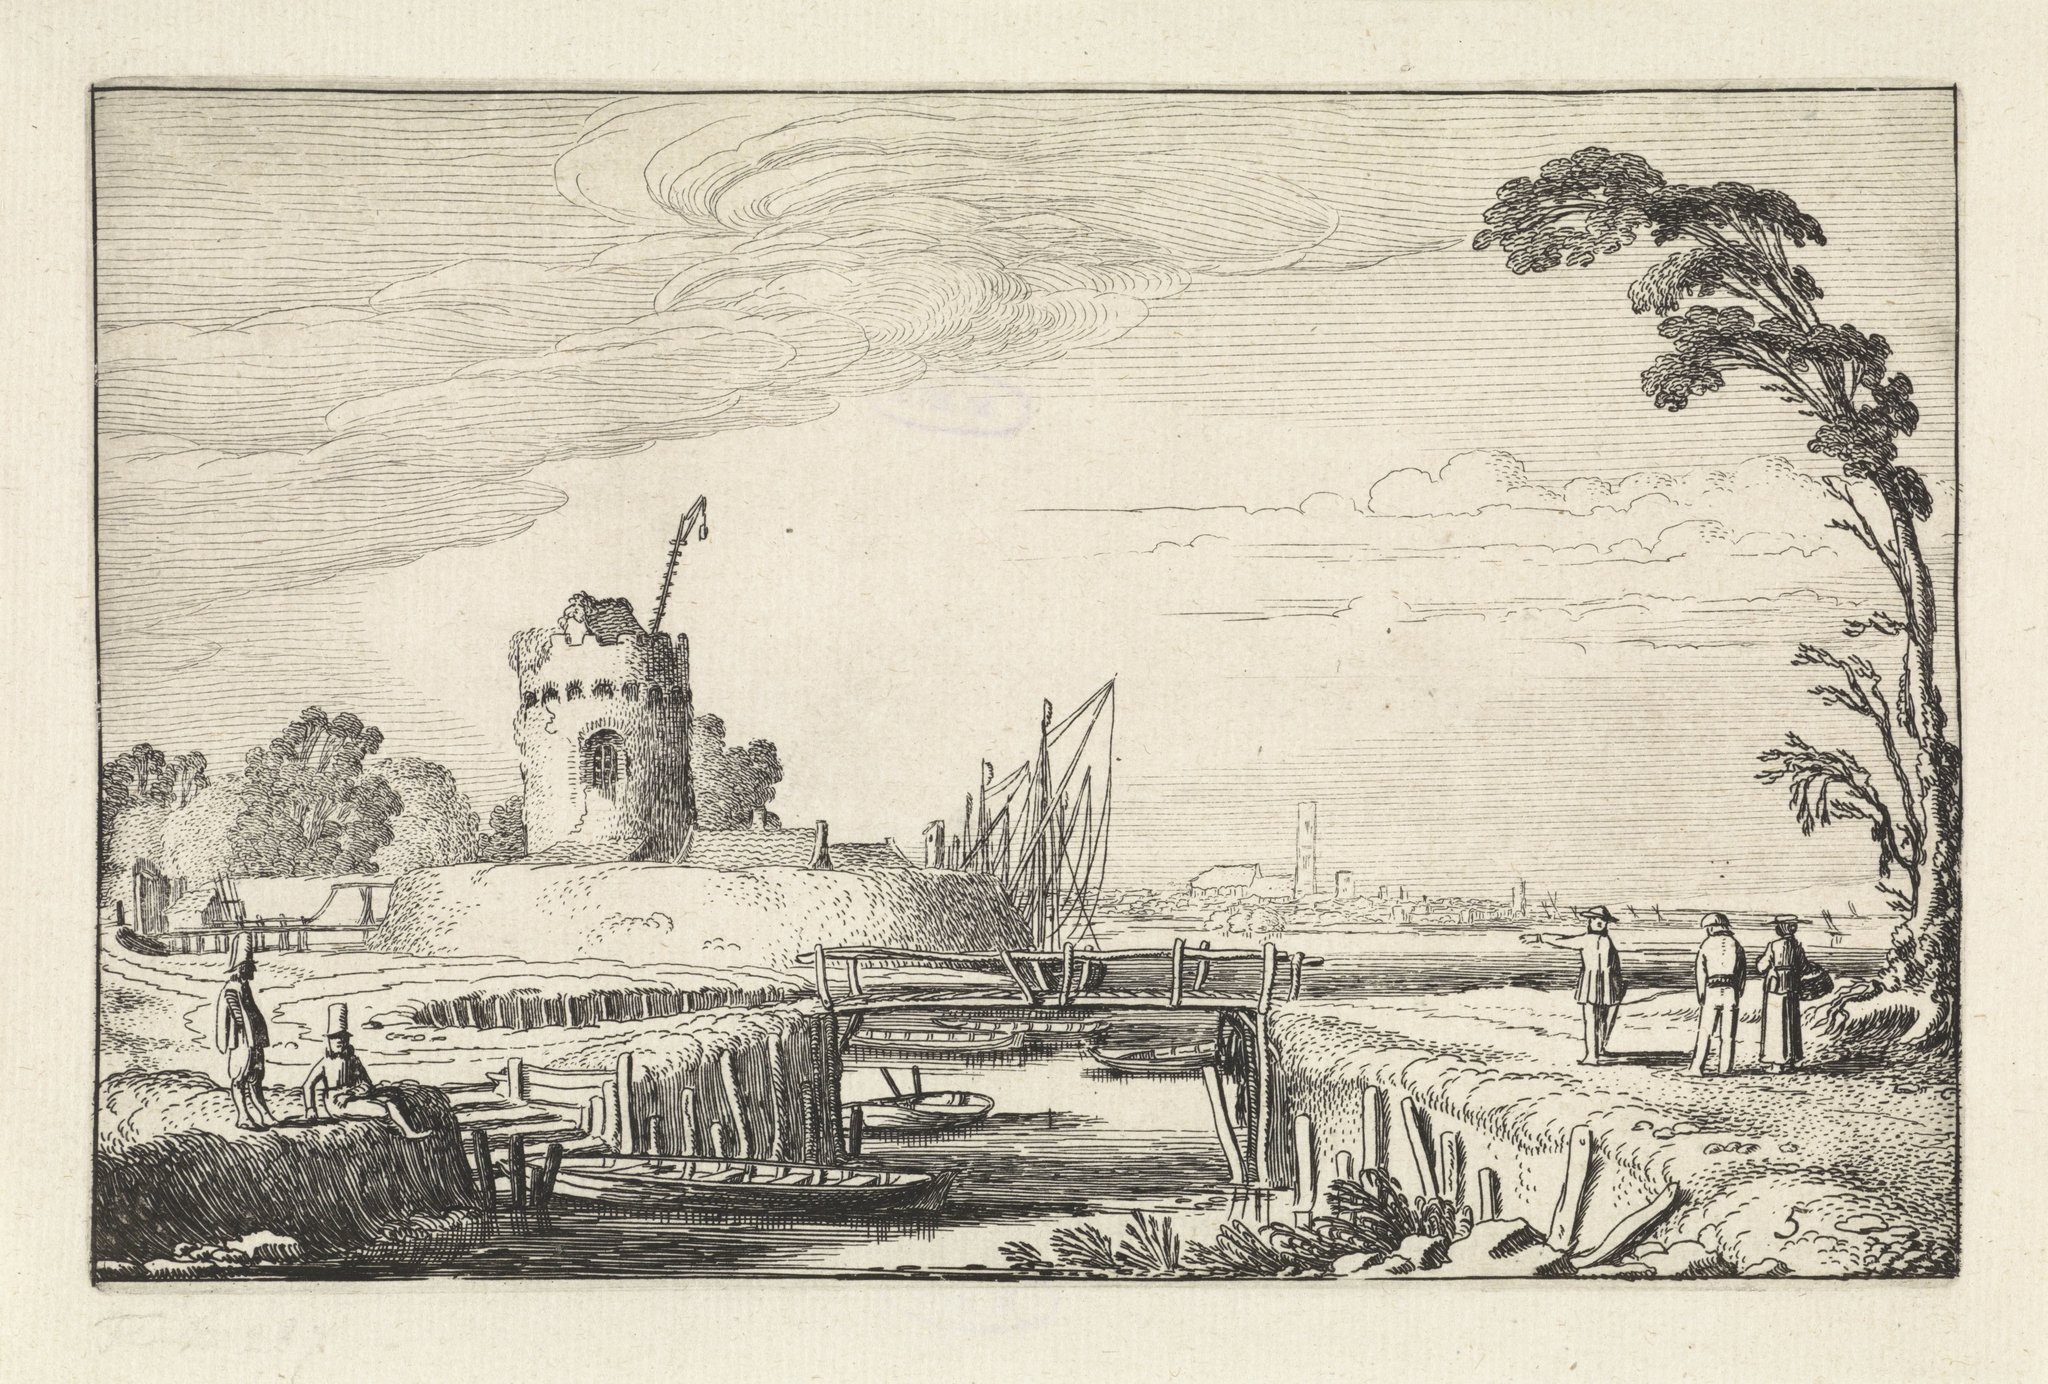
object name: print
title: Amenissimae aliquot requculae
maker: jan van de velde (ii)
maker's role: draughtsman, painter, print maker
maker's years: 1593-1641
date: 1616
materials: paper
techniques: etching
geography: northern netherlands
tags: harbour, lighthouse, lightship, bridges by construction, landscape with tower or castle, pier, quay, wharf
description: Figuren bij een haven bij een toren, die als vuurtoren wordt gebruikt. Tussen de kades een houten brug. Aan de horizon een stad. Vijfde prent van deel twee van een serie van in totaal zestig prenten met landschappen, verdeeld over vijf delen van elk twaalf prenten.